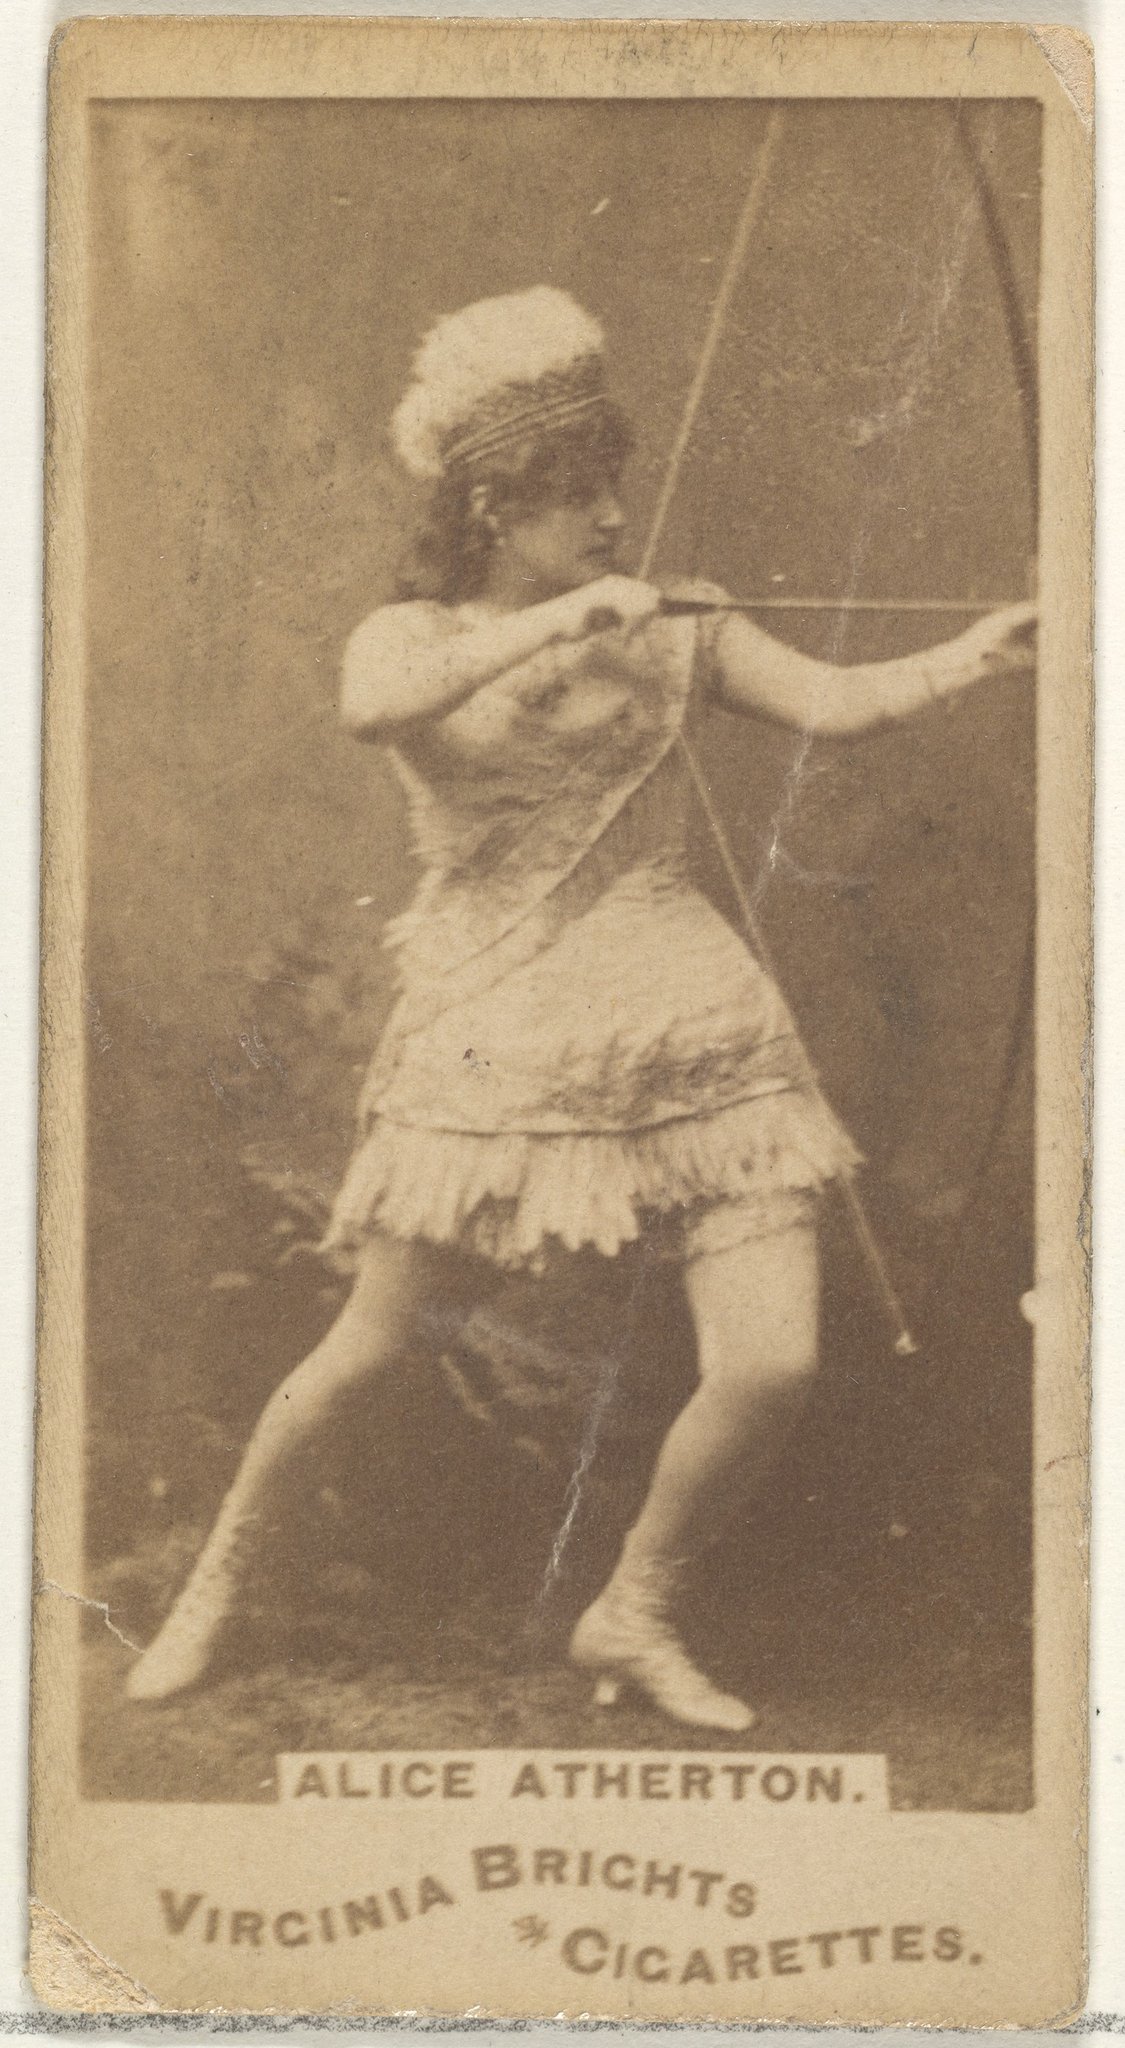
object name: photograph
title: Alice Atherton, from the Actors and Actresses series (N45, Type 1) for Virginia Brights Cigarettes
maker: allen & ginter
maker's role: publisher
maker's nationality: american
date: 1888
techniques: albumen silver print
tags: bow and arrow,portraits,women,actresses